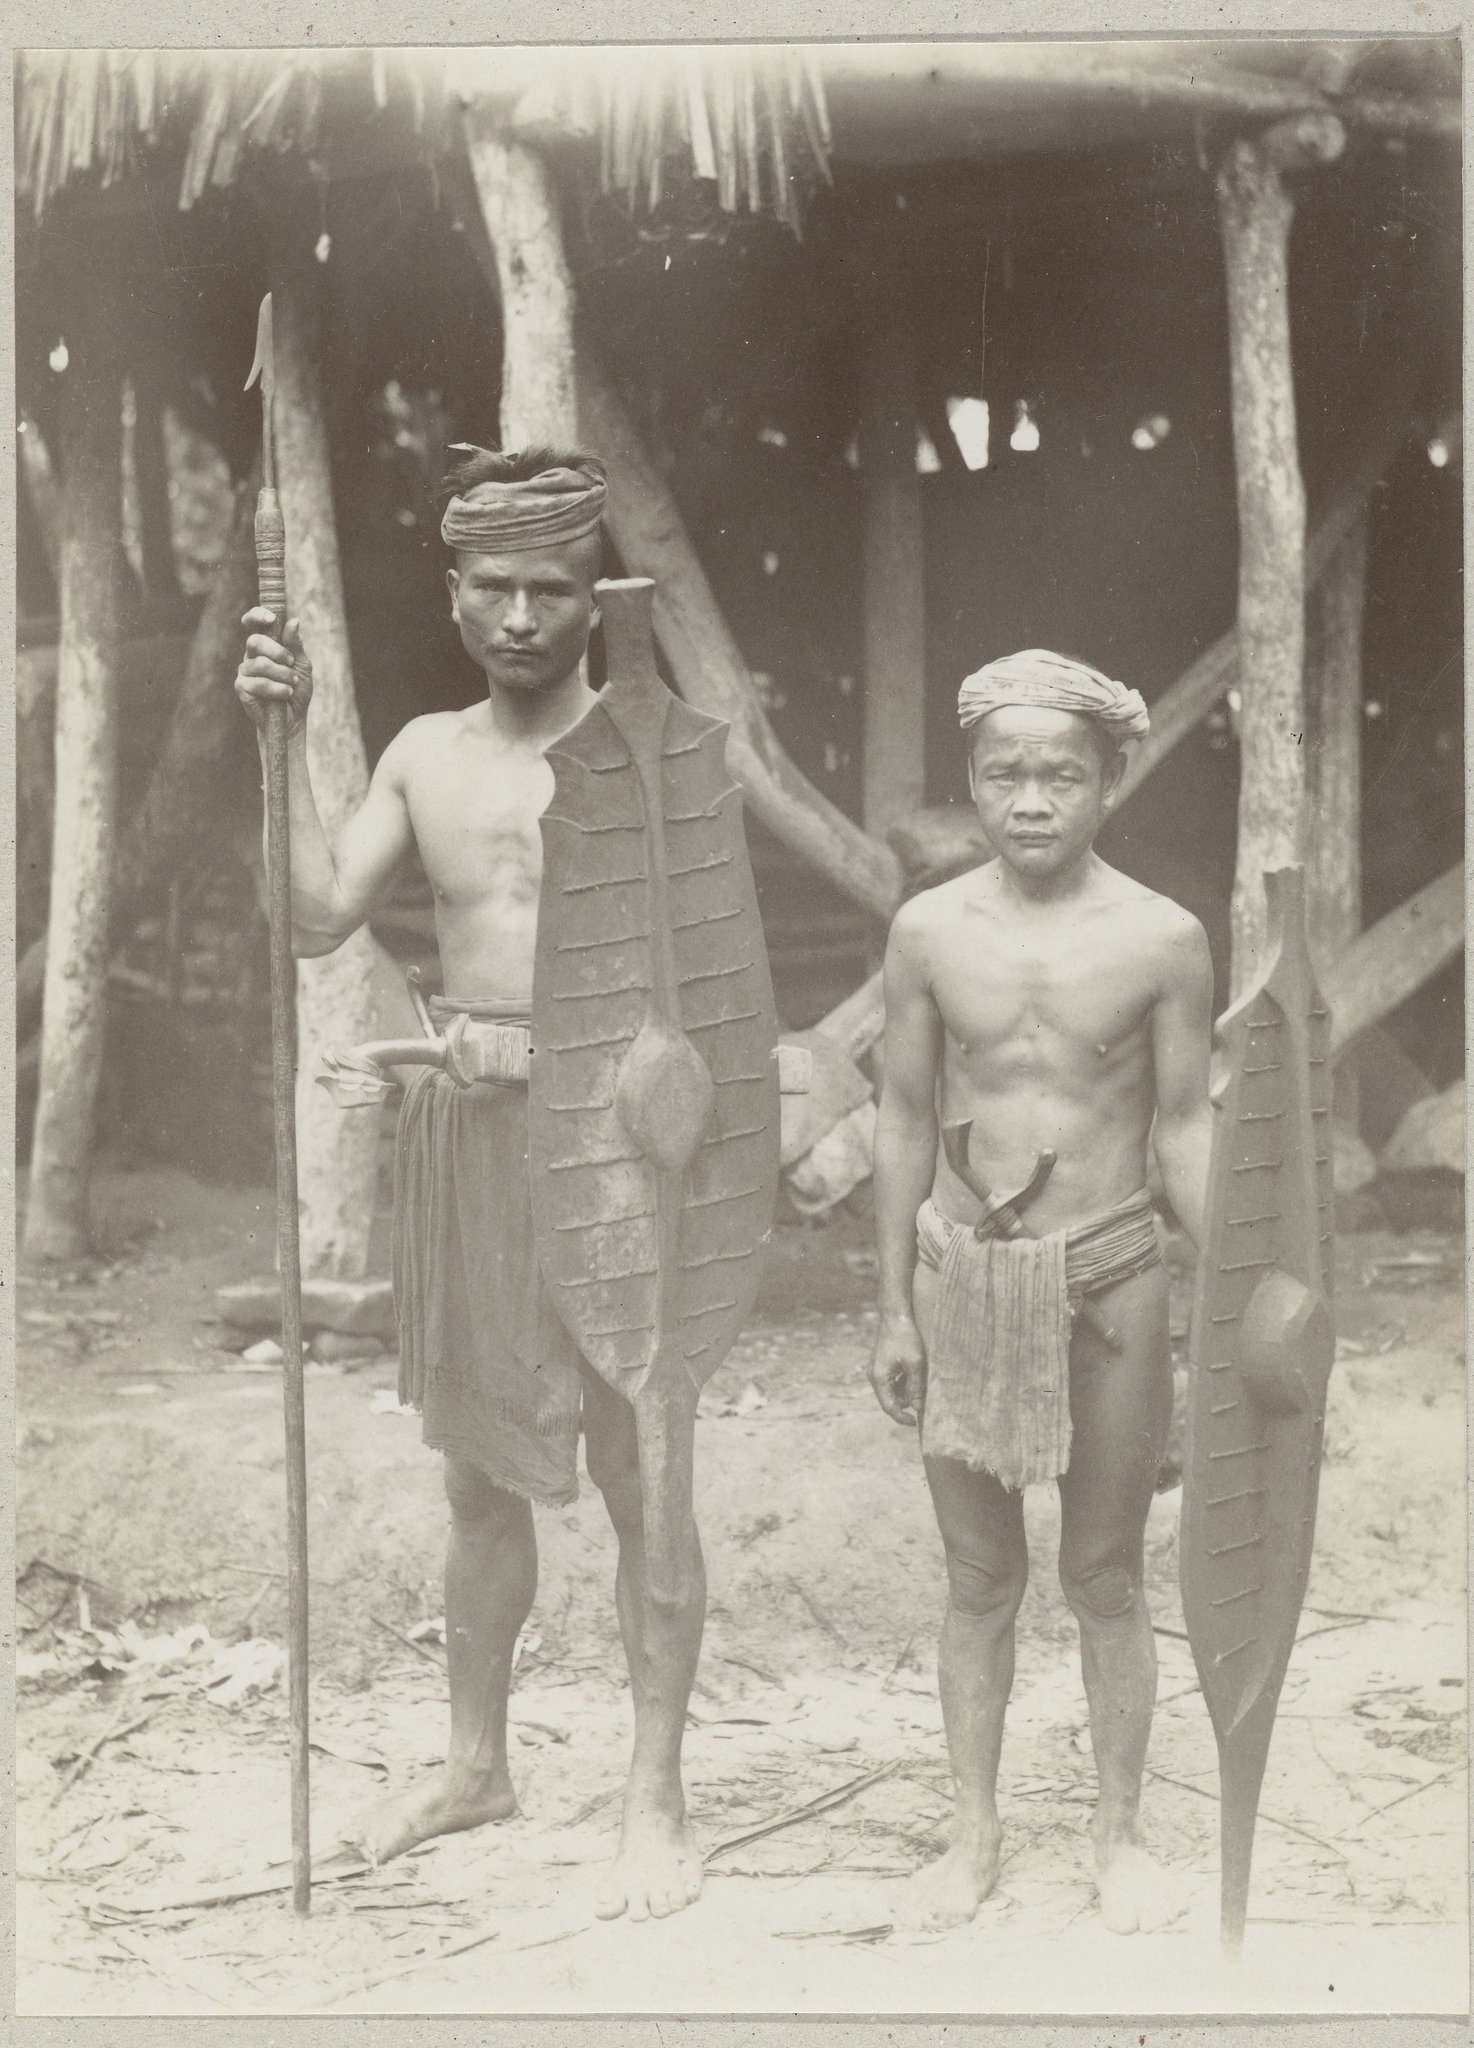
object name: photograph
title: Portret van twee onbekende Indonesische strijders of jagers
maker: christiaan benjamin nieuwenhuis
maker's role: publisher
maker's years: 1863-1922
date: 1891-1912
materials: paper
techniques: albumen print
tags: group-portrait of hunters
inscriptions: inscription: ‘[...]’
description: Twee mannen dragen een houten schild en speren. Rond het middel dragen ze een mes